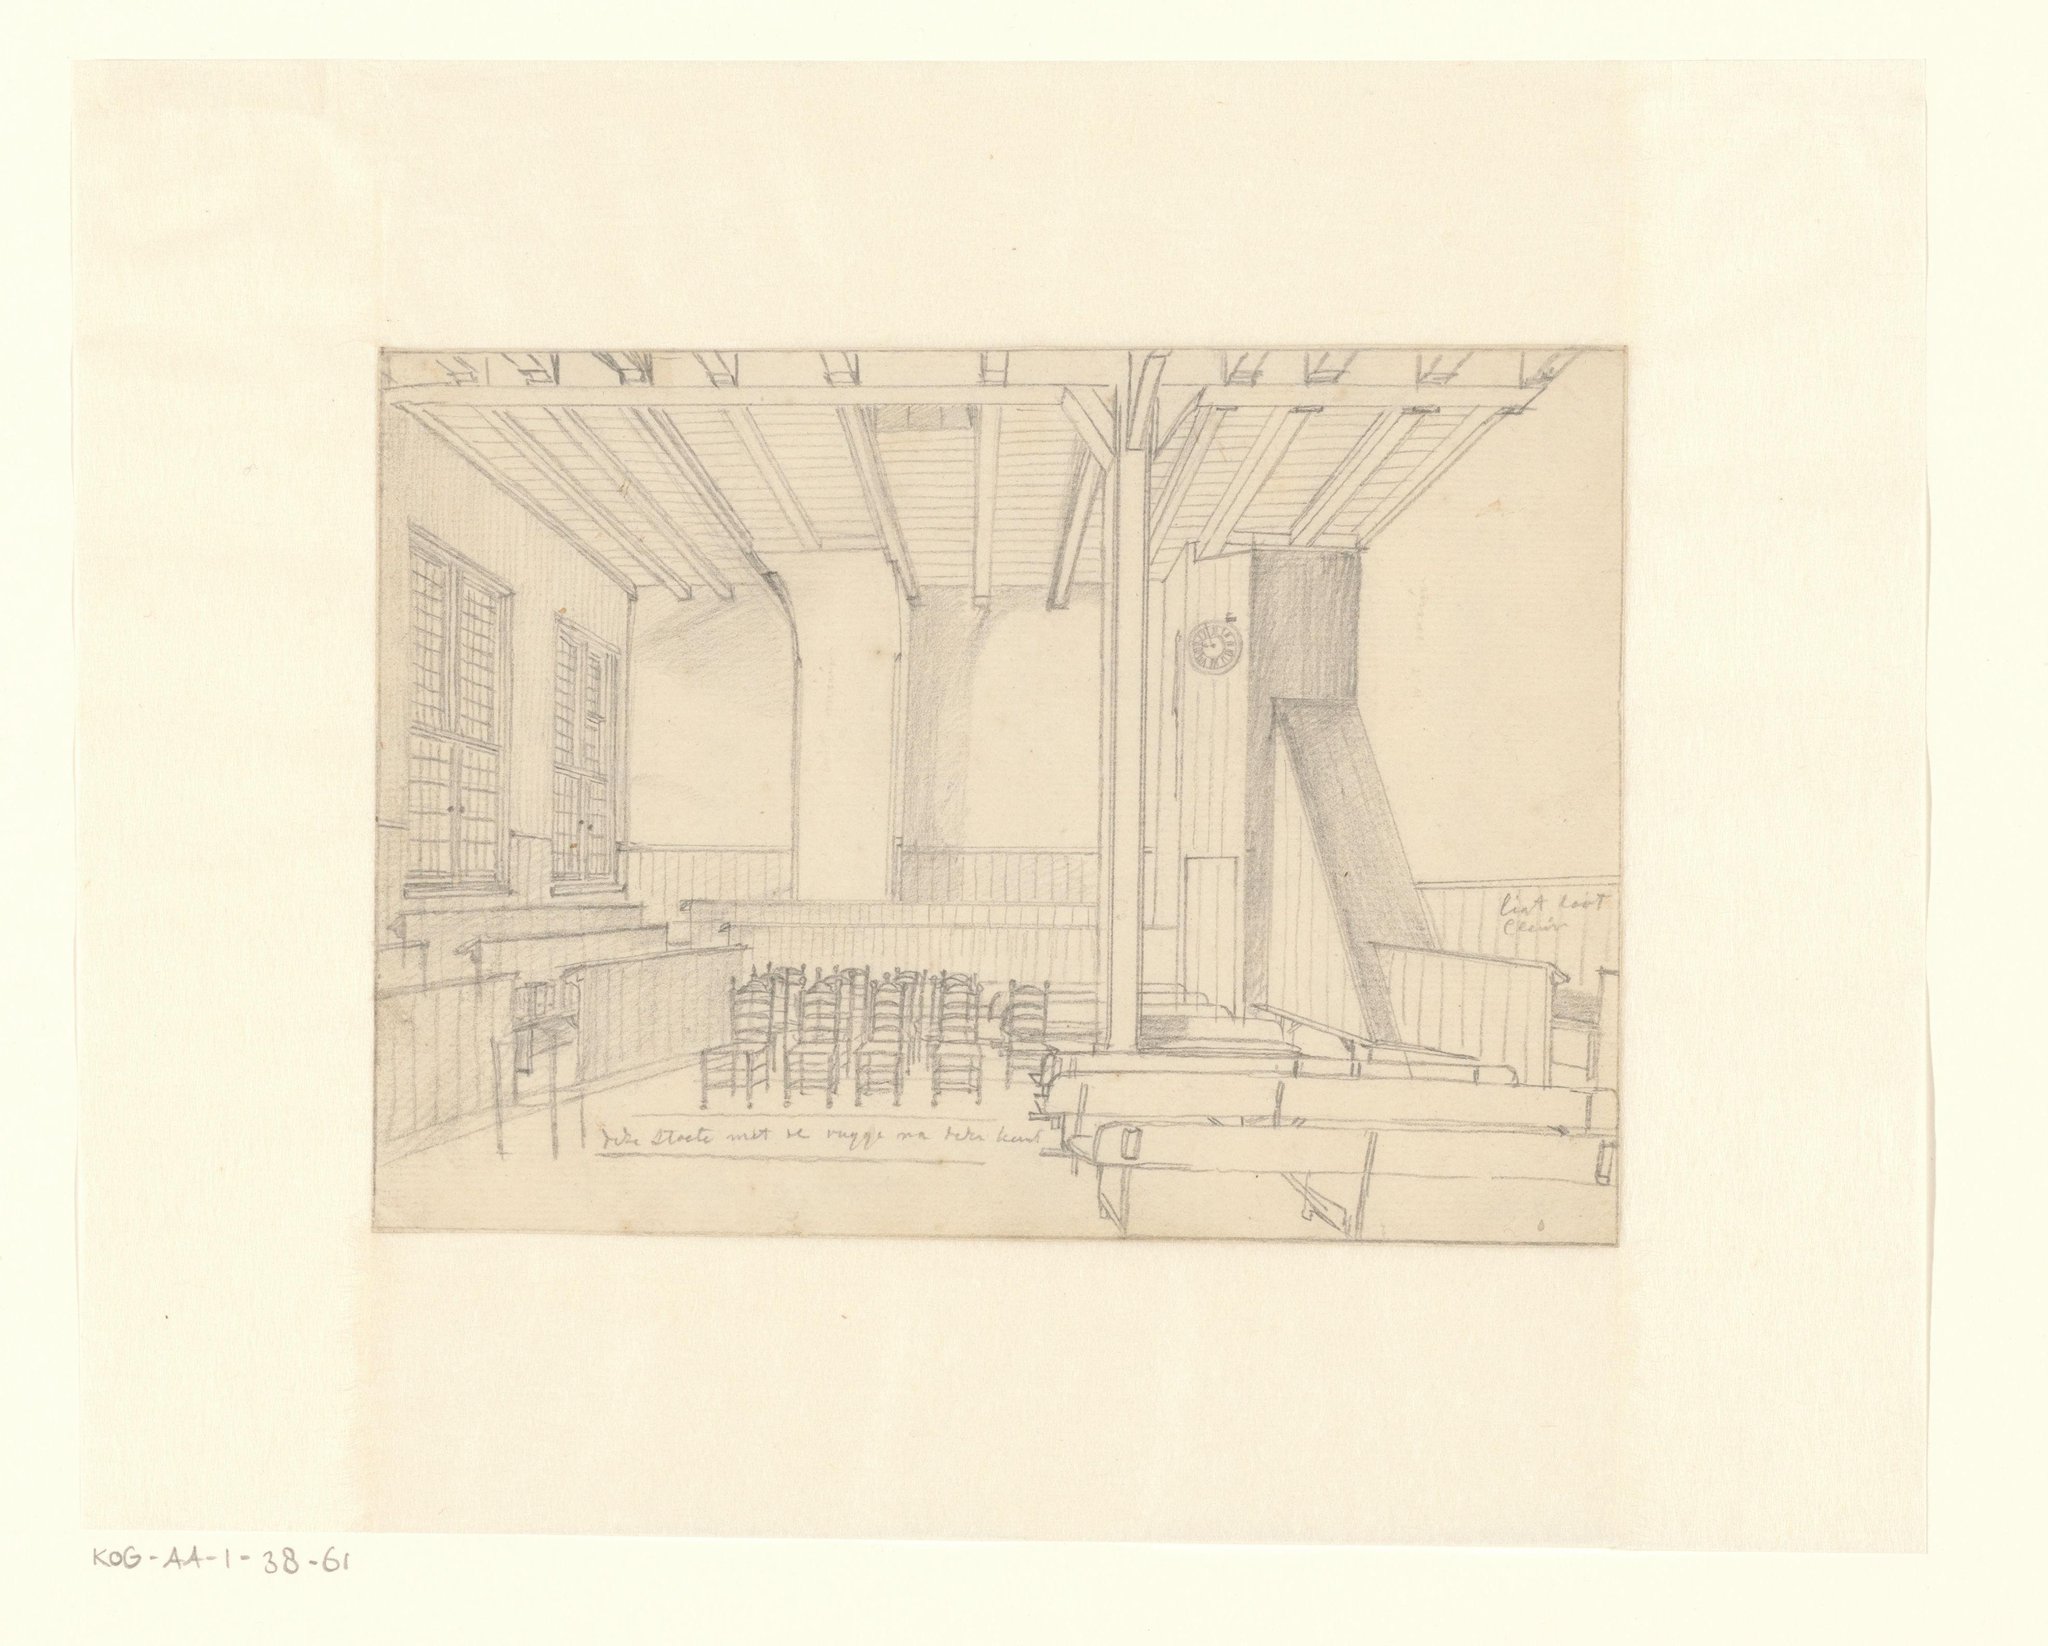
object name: drawing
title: Interieur van de voormalige kerkenkamer van het Weeshuis der Doopsgezinde Collegianten de Oranjeappel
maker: Anonymous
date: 1800-1850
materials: paper, pencil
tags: communal rooms, orphanage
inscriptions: inscription: ‘lint laat / clein / deze stoele met de rugge na t[...] kant’, inscription: ‘Colesiante Camer / in de Oranje appel’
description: Onderwerpsrubriek binnen de Atlas Amsterdam: Inrichtingen der Doopsgezinden.